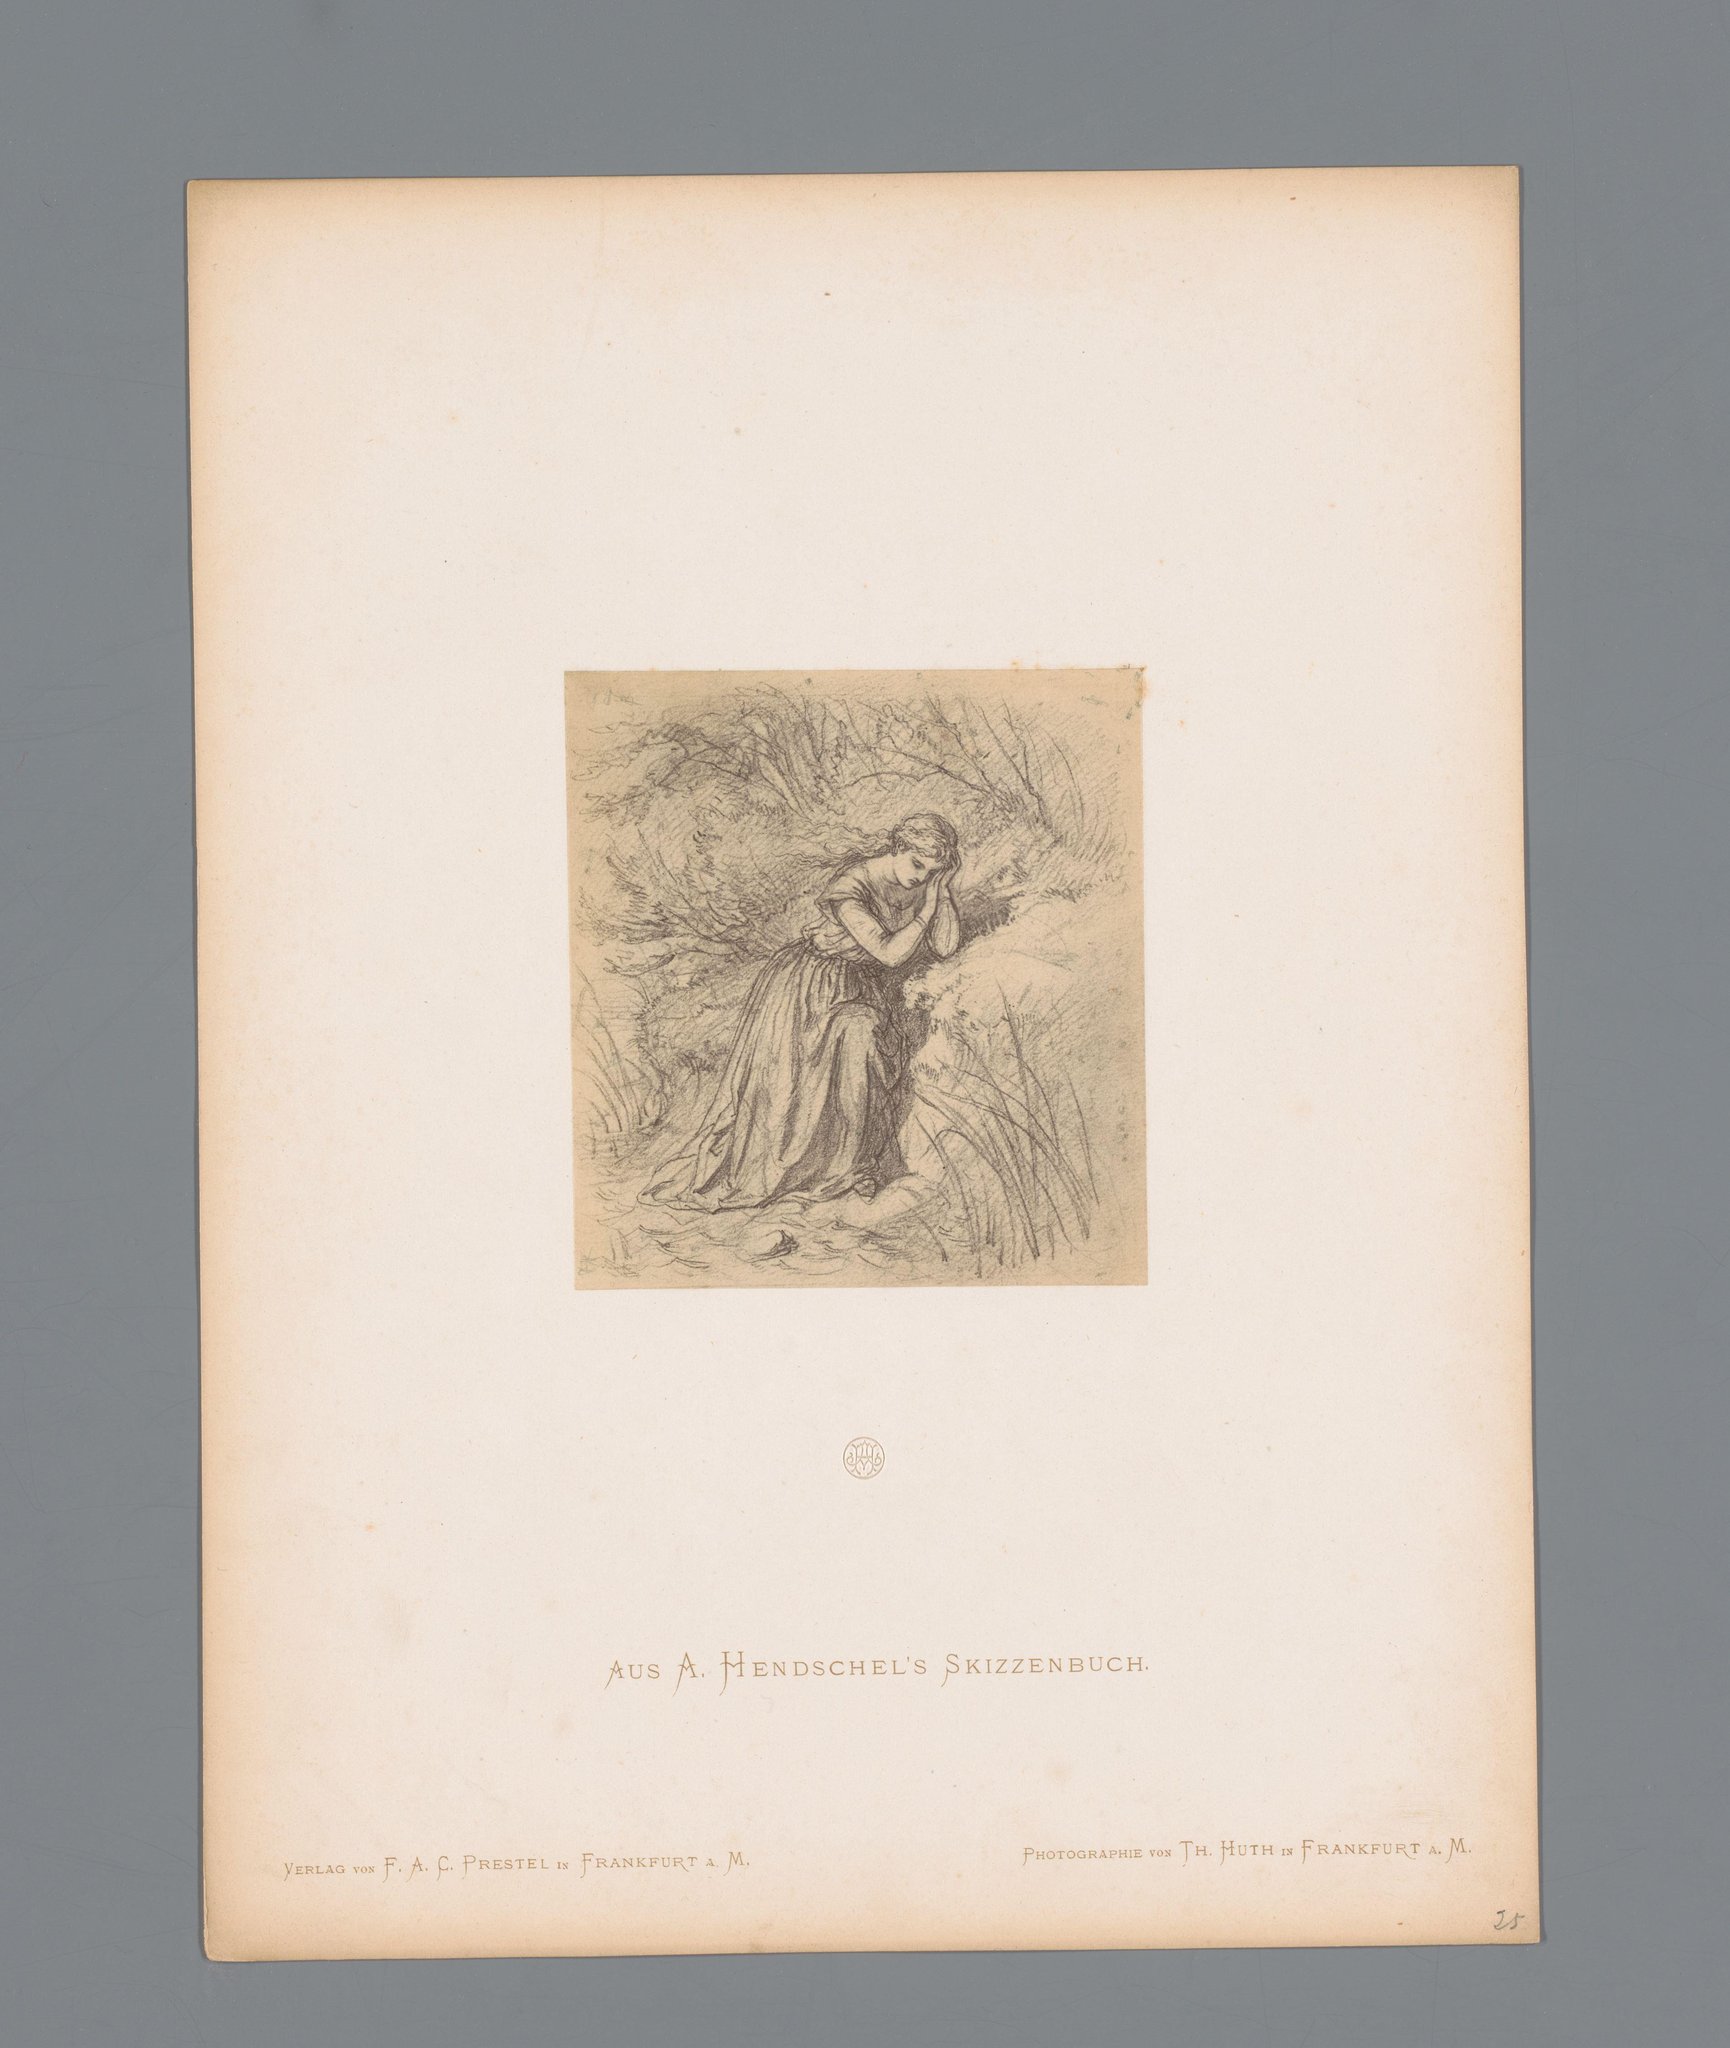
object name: photograph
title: Fotoreproductie van een schets van een treurende vrouw door Albert Hendschel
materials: photographic support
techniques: albumen print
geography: frankfurt am main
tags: weeping (+ young female (human being))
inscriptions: number: ‘25’, monogram: ‘AH’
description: Deze foto maakt deel uit van een omslag met 50 foto's op 48 bladen, een lijst van afbeeldingen en een titelblad.